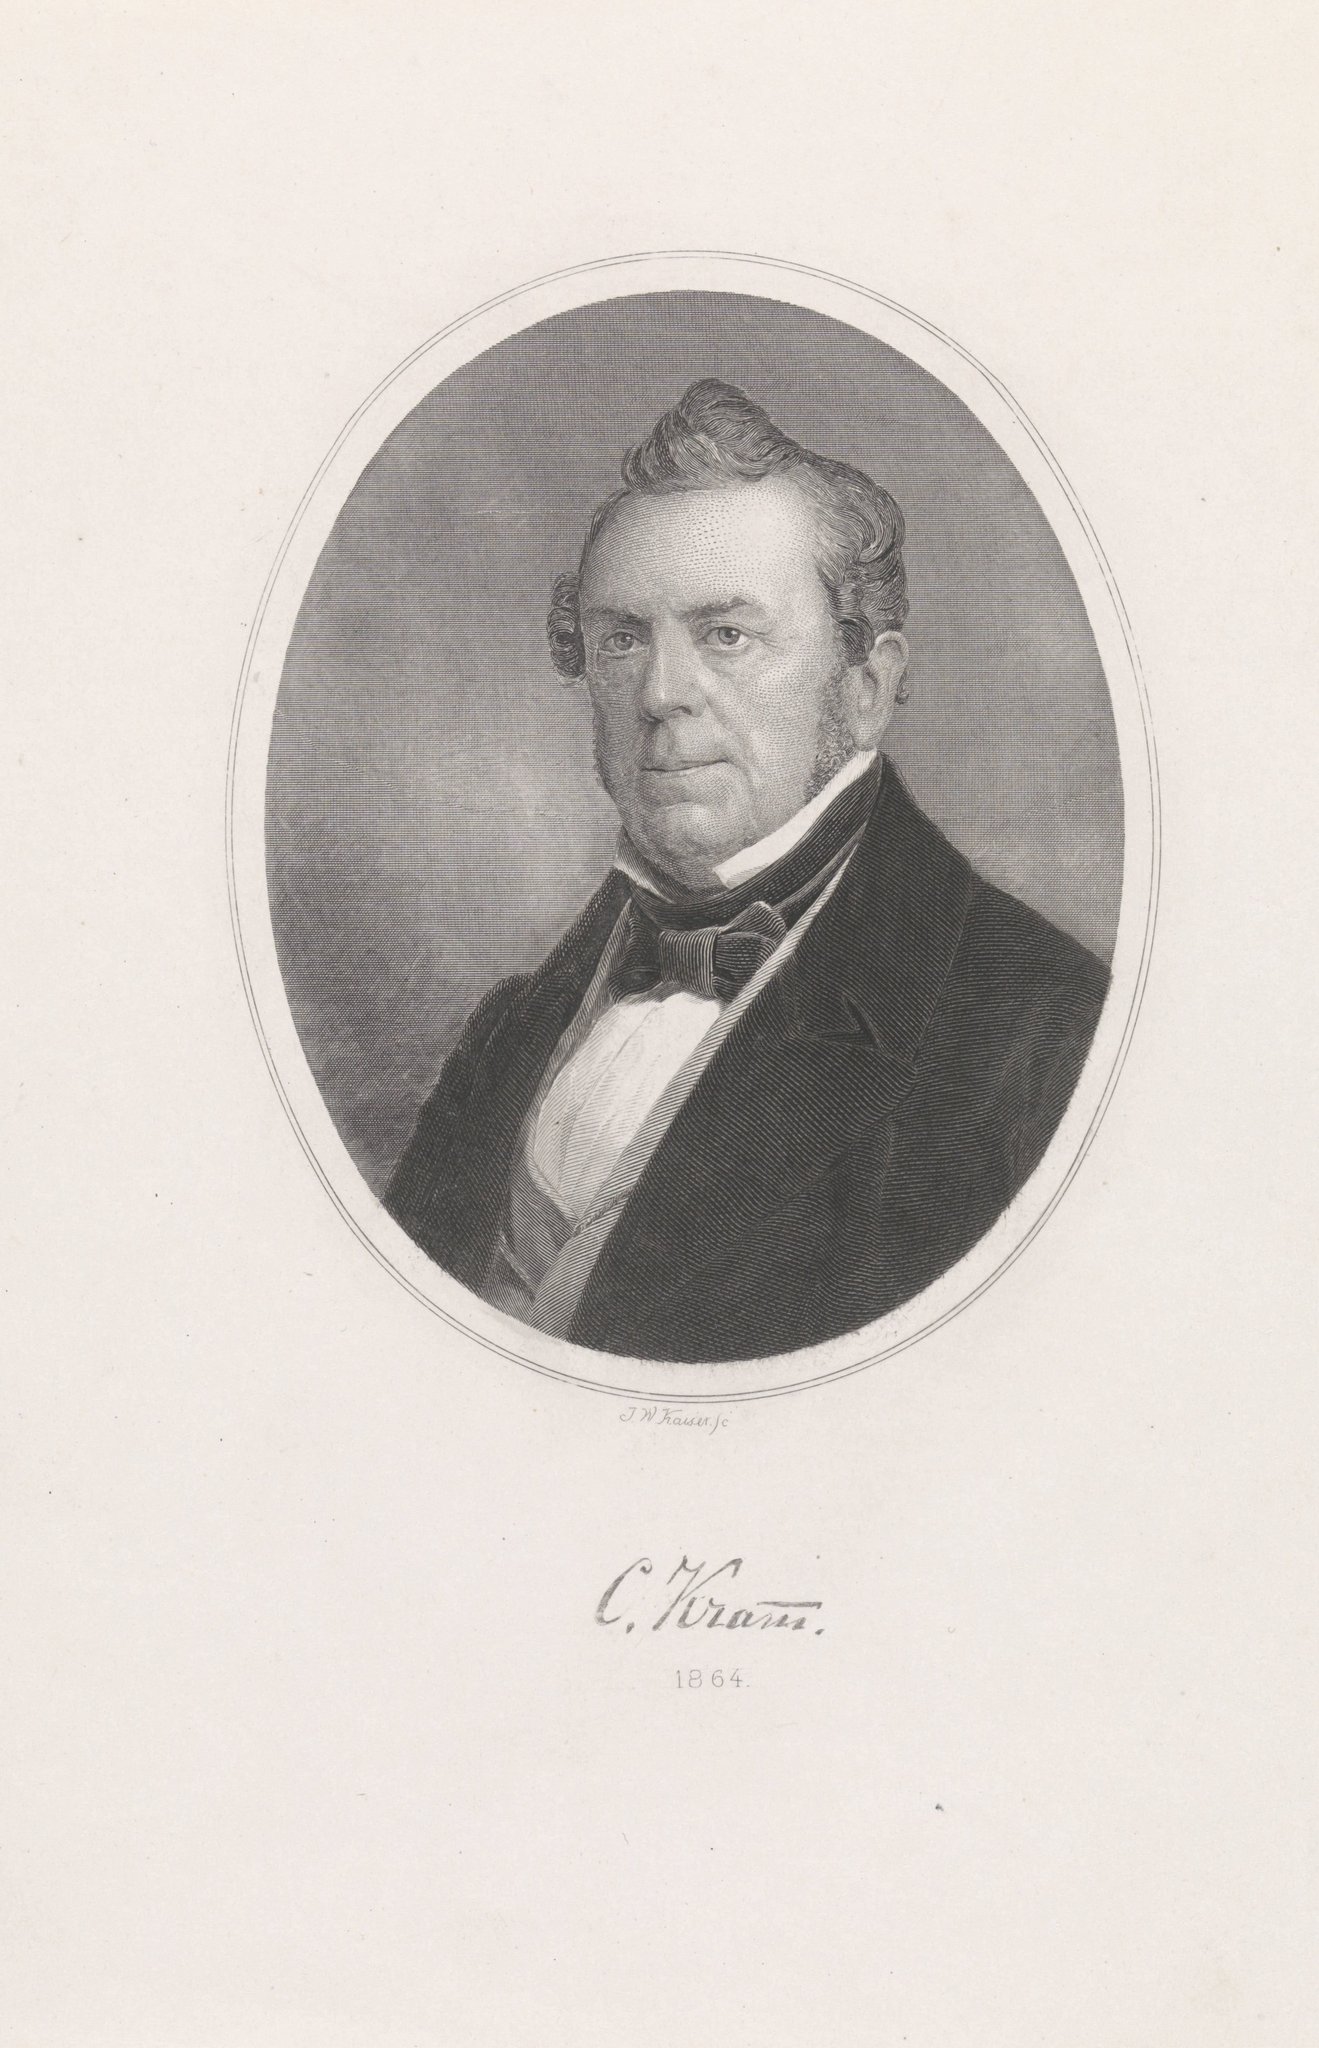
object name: print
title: Portret van Christiaan Kramm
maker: johann wilhelm kaiser (i)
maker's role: draughtsman, print maker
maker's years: 1813-1900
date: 1864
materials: paper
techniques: brush, etching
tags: utrecht, print maker, draughtsman, christiaan kramm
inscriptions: collector's mark: Lugt 2228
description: Portretbuste in ovaal naar links van schrijver en beeldend kunstenaar Christiaan Kramm.